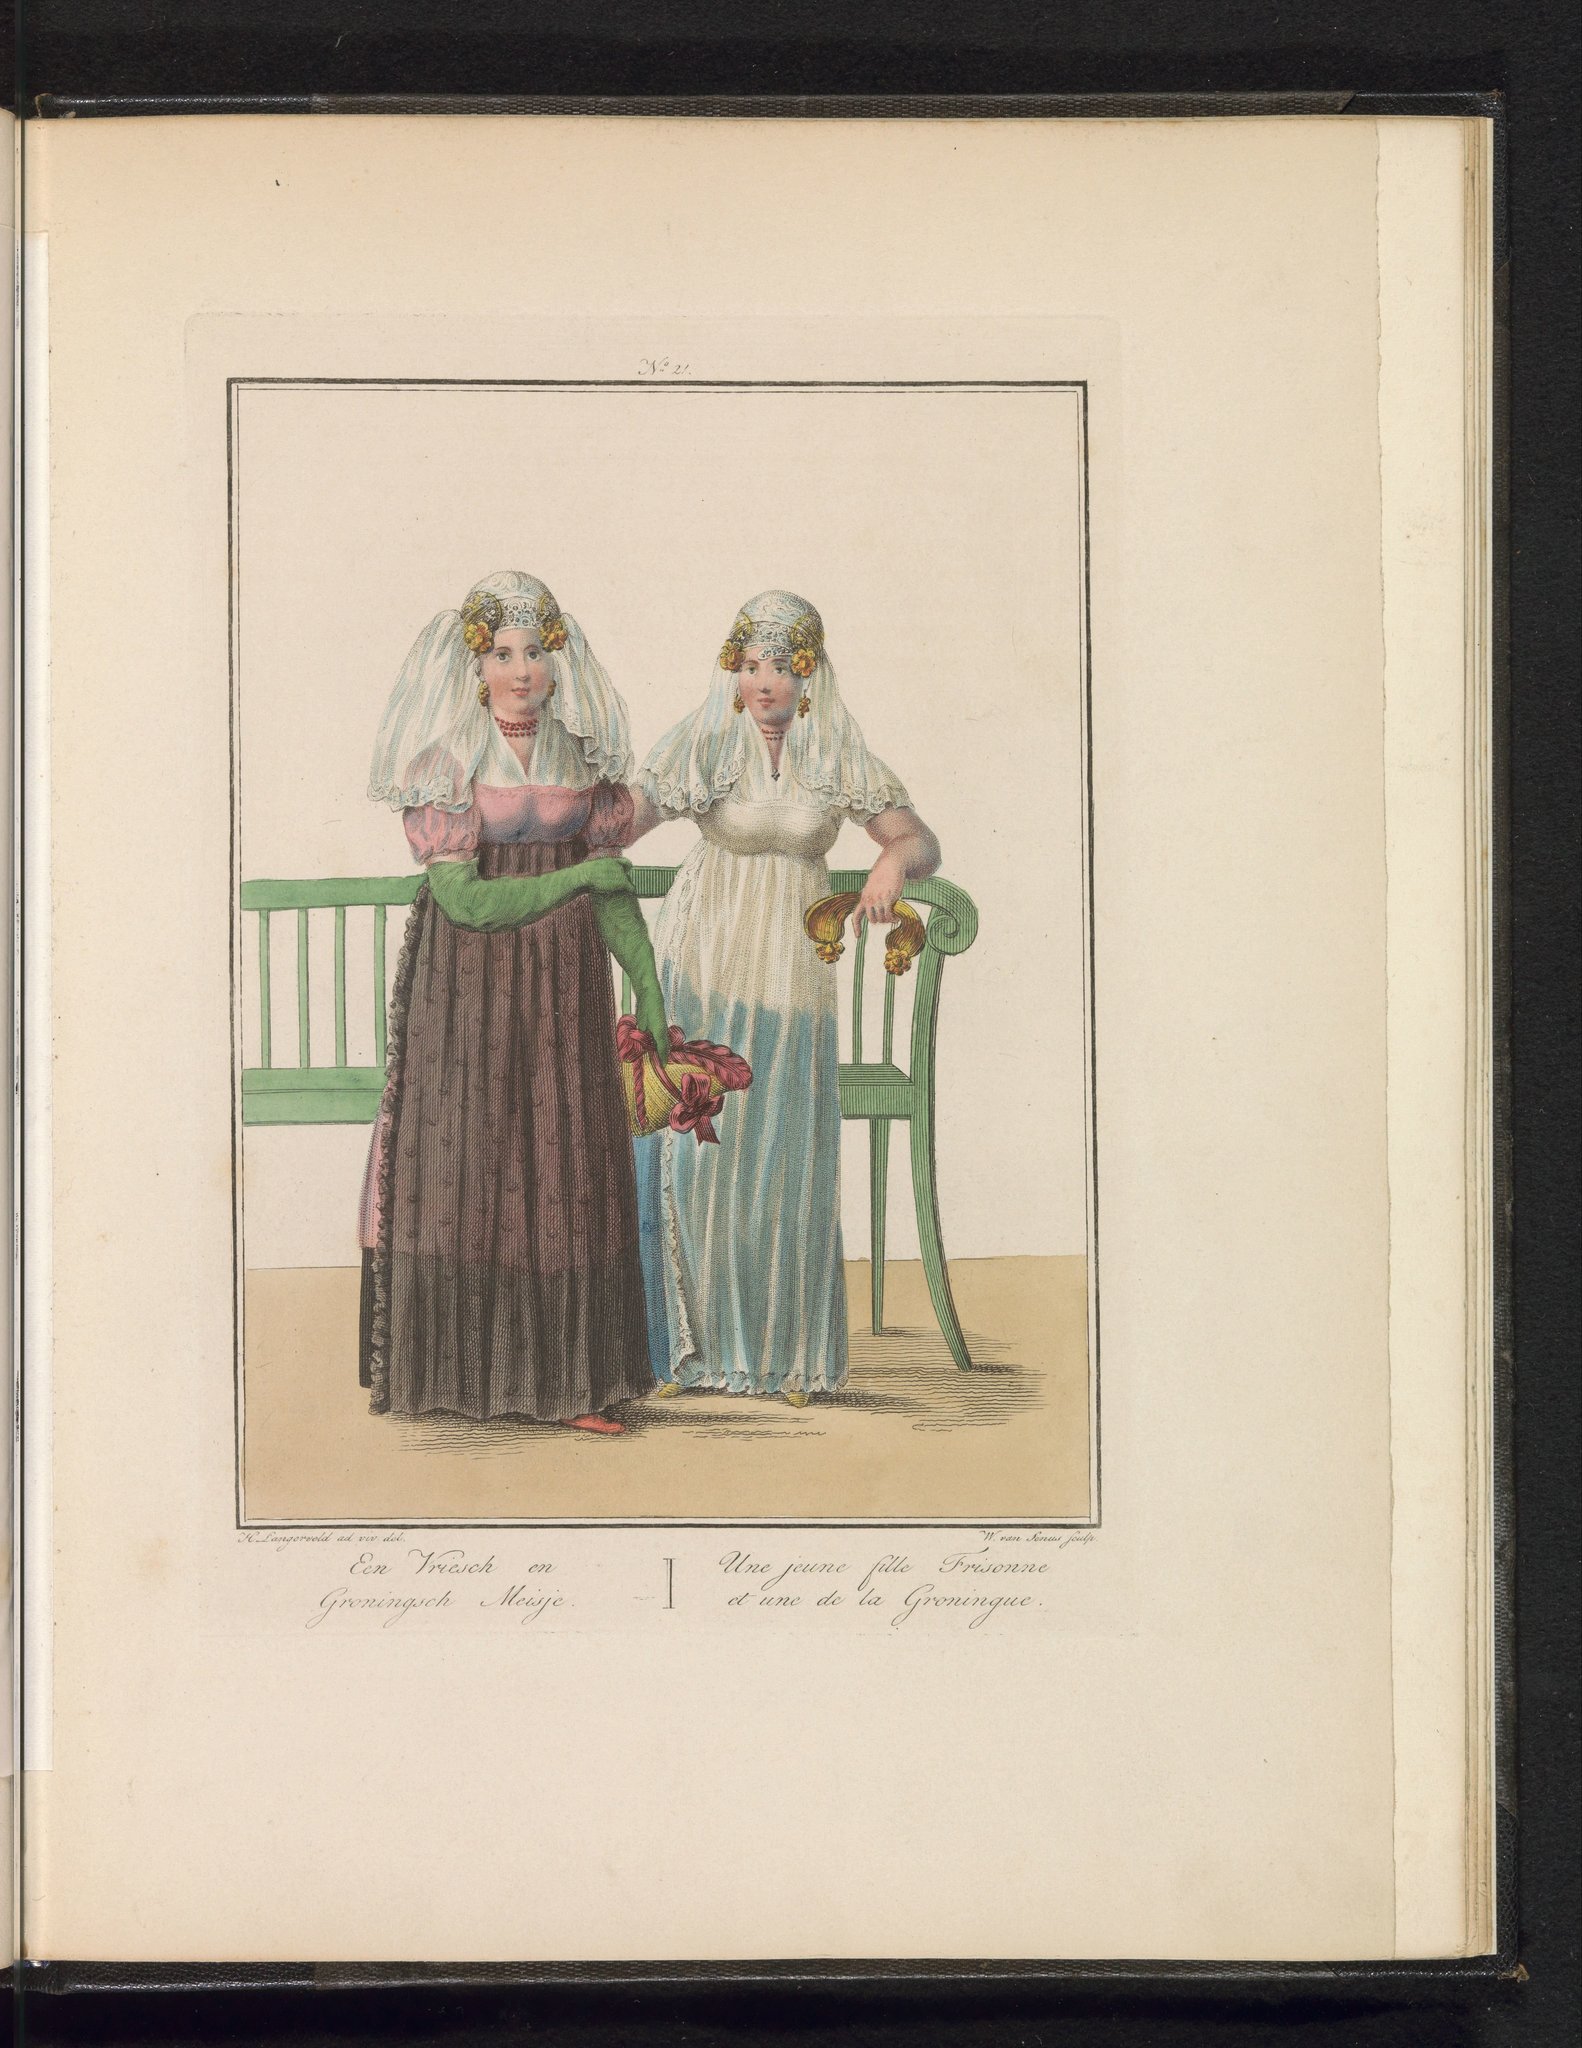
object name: costume print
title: Een Fries en een Gronings meisje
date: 1823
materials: paper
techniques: etching, hand coloring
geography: netherlands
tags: folk costume, regional costume, clothes, costume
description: Gebruikt als illustratie in: Evert Maaskamp, Afbeeldingen van de kleedingen, zeden en gewoonten in de noordelijke provincien van het Koningrijk der Nederlanden, met den aanvang der negentiende eeuw = Tableaux des habillemens, mœurs et coutumes dans les provinces septentrionales du Royaume des Pays-Bas, au commencement du dix-neuvième siècle. Amsterdam: Evert Maaskamp, 1829 [heruitgave van de oorspronkelijke platen eerst verschenen in 1803-1807].